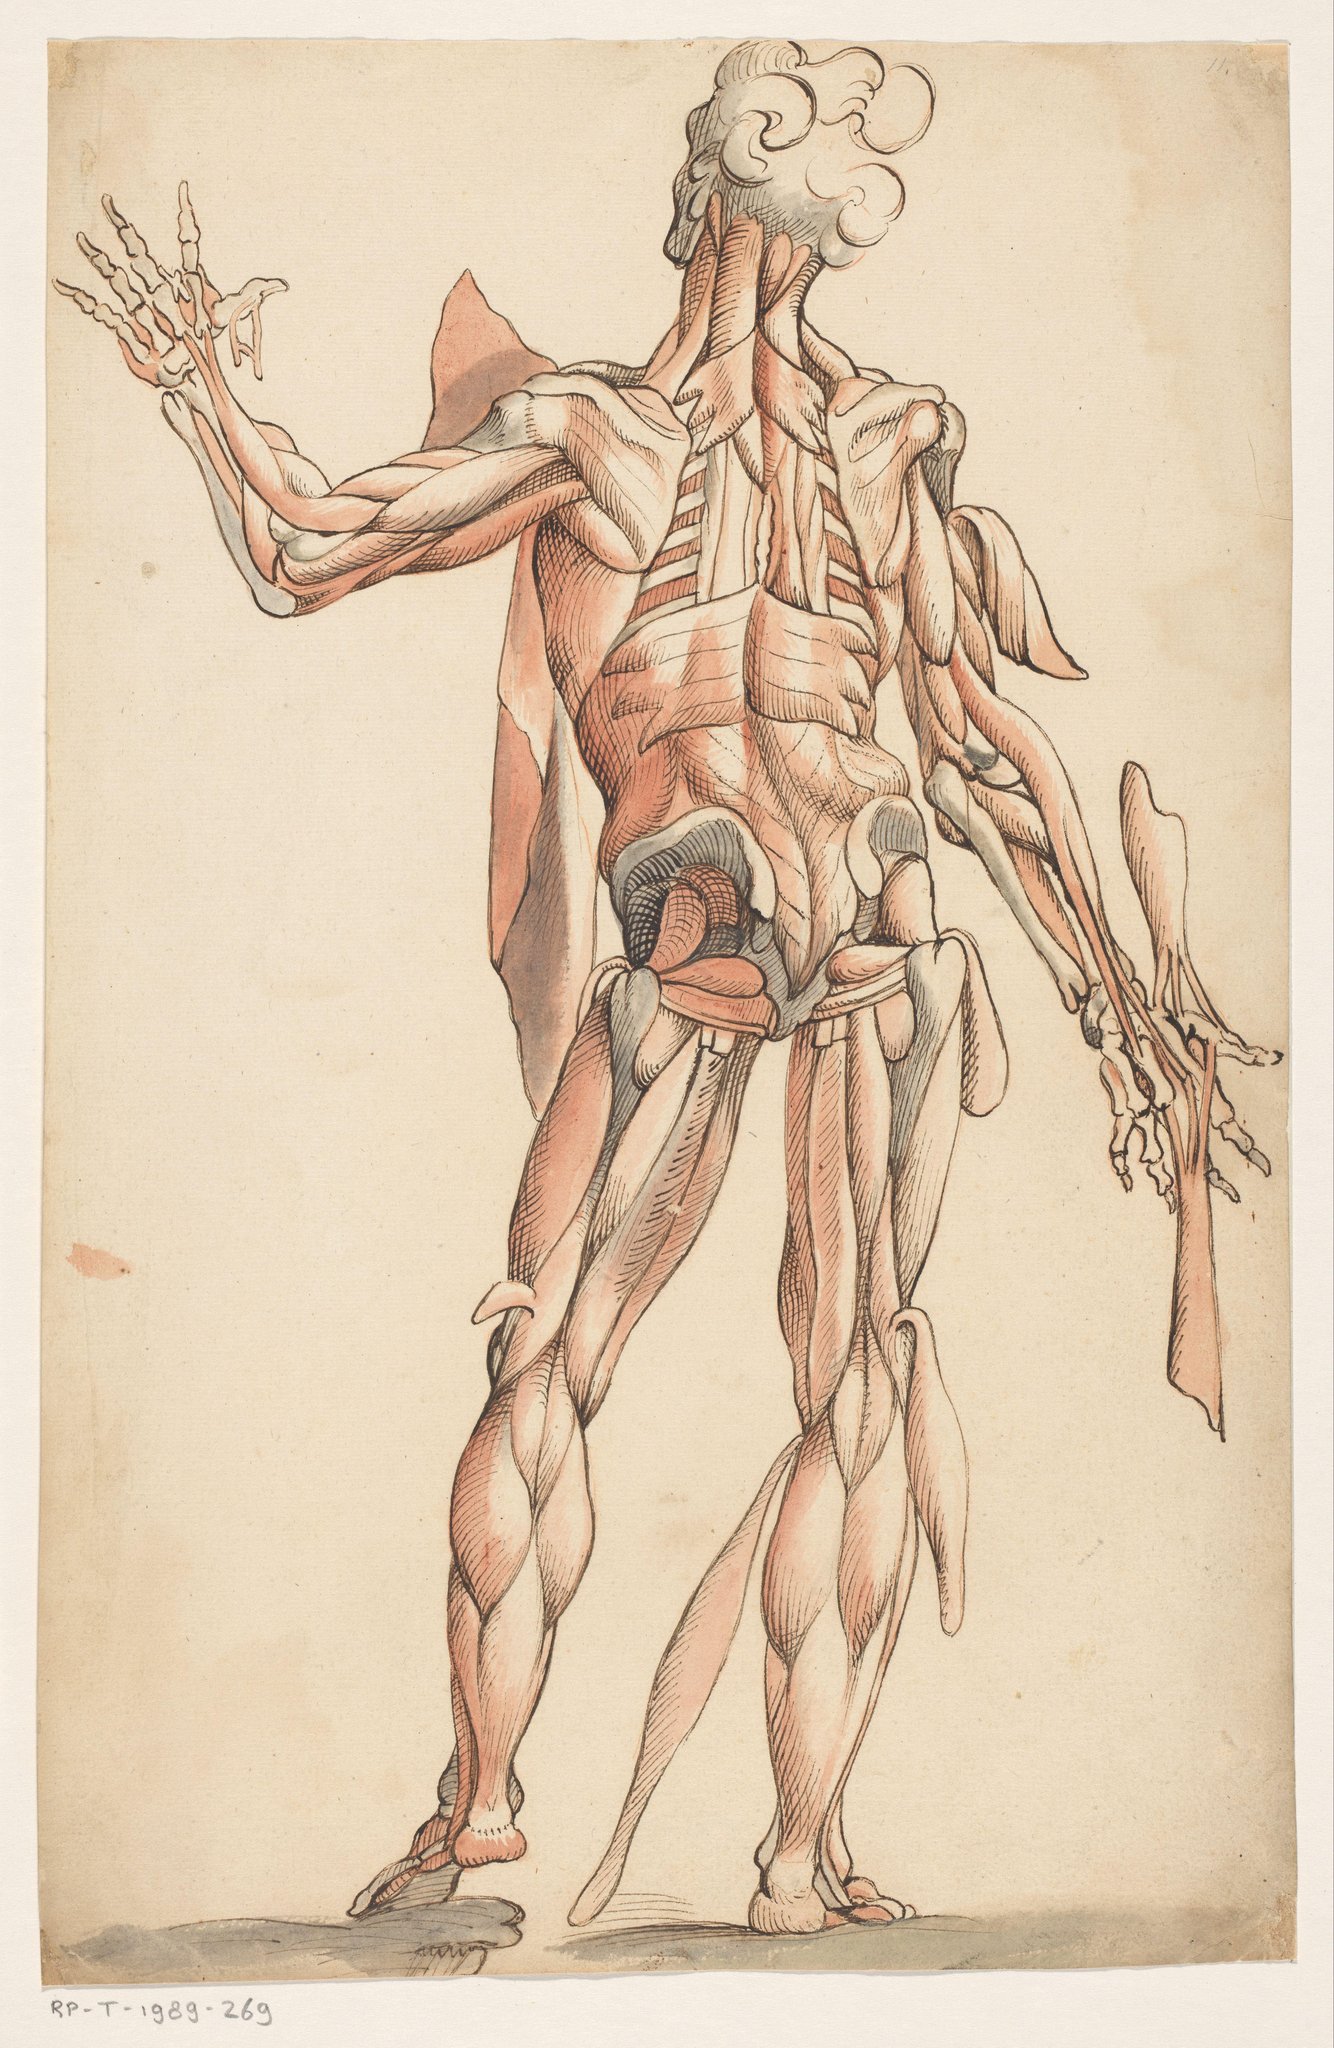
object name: drawing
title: Spieren en skelet van het menselijk lichaam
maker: Anonymous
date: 1600-1649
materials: ink, paper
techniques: brush, pen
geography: low countries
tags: muscles, (human) skeleton, anatomical model of the muscles, muscle-man, 'écorché'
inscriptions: collector's mark: Lugt 2228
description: De tekening komt sterk overeen met een prent in: Gracht, Jacob van der. Anatomie der wtterlicke deelen van het menschelick lichaem (...). Den Haag: Jacob van der Gracht, 1634. De tekening is echter gespiegeld en zou mogelijk als voorbeeld voor de prent kunnen hebben gediend. De houding waarin het lichaam is afgebeeld gaat terug tot: Vesalius, Andreas. De humani corporis fabrica libri septem (...). Bazel: Johannes Oporinus, 1543. Tekening zit in een omslag met meerdere anatomische tekeningen, genummerd RP-T-1989-256 en RP-T-1989-258 t/m RP-T-1989-289.